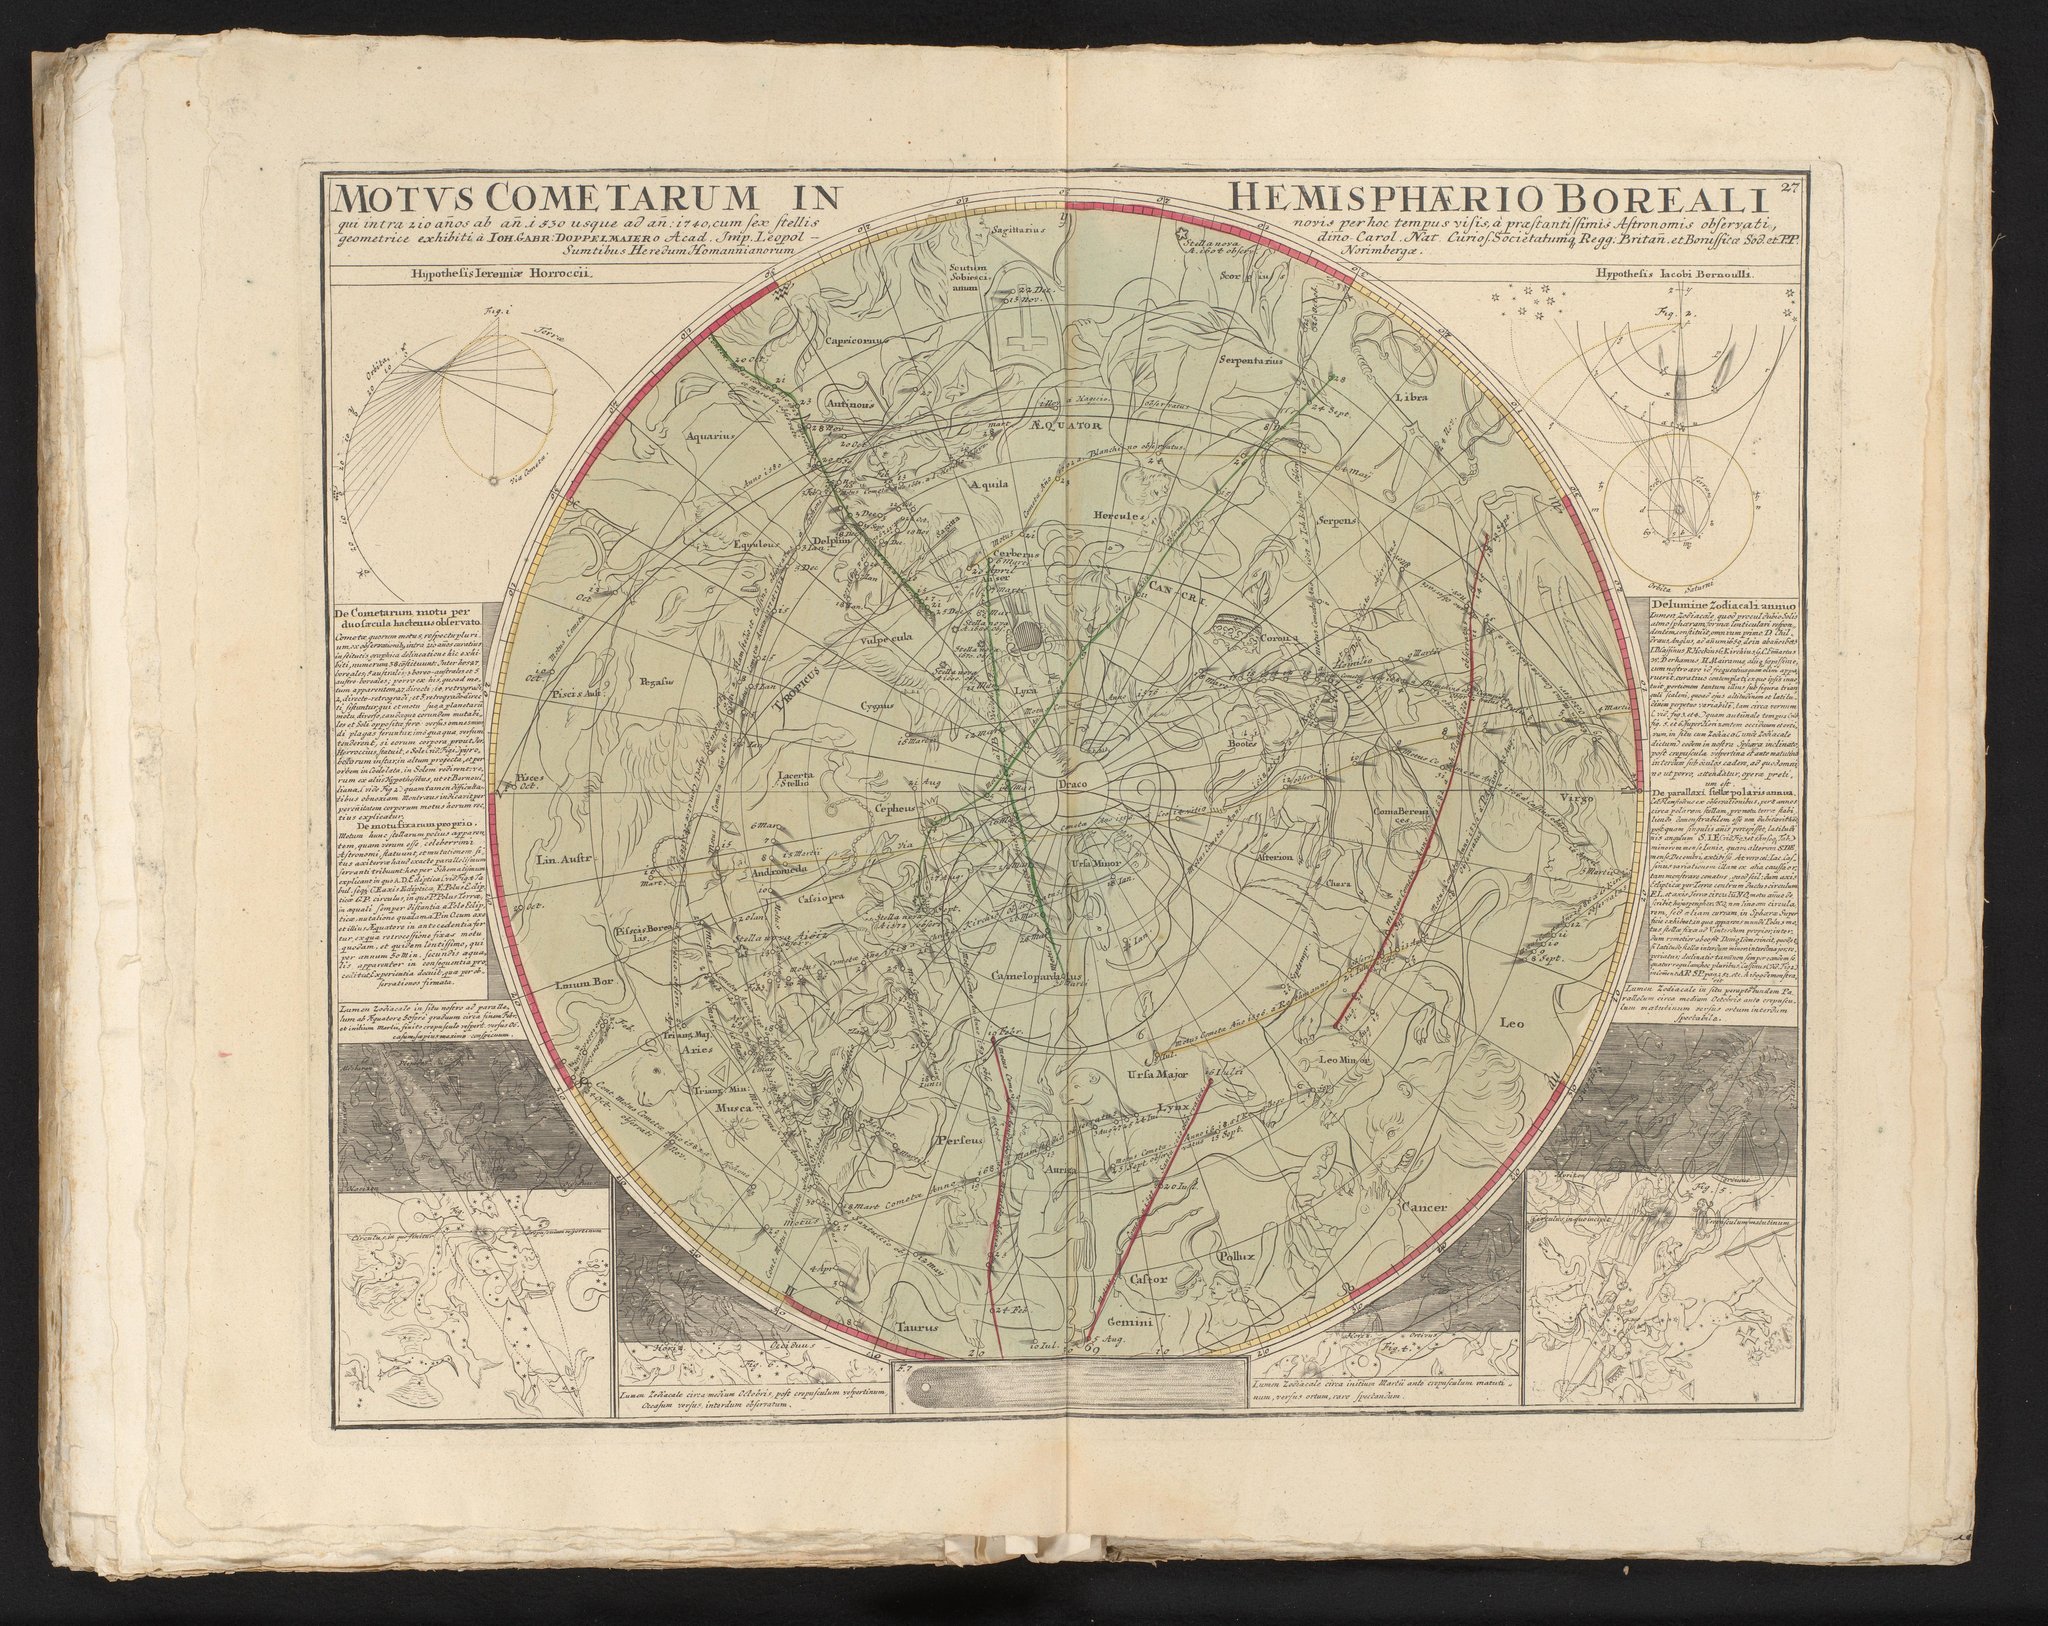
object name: print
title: Motus cometarum in hemisphaerio boreali qui intra (...)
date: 1742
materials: paper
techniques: engraving, etching, hand coloring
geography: nuremberg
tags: comet, star-chart, star map, stars and constellations